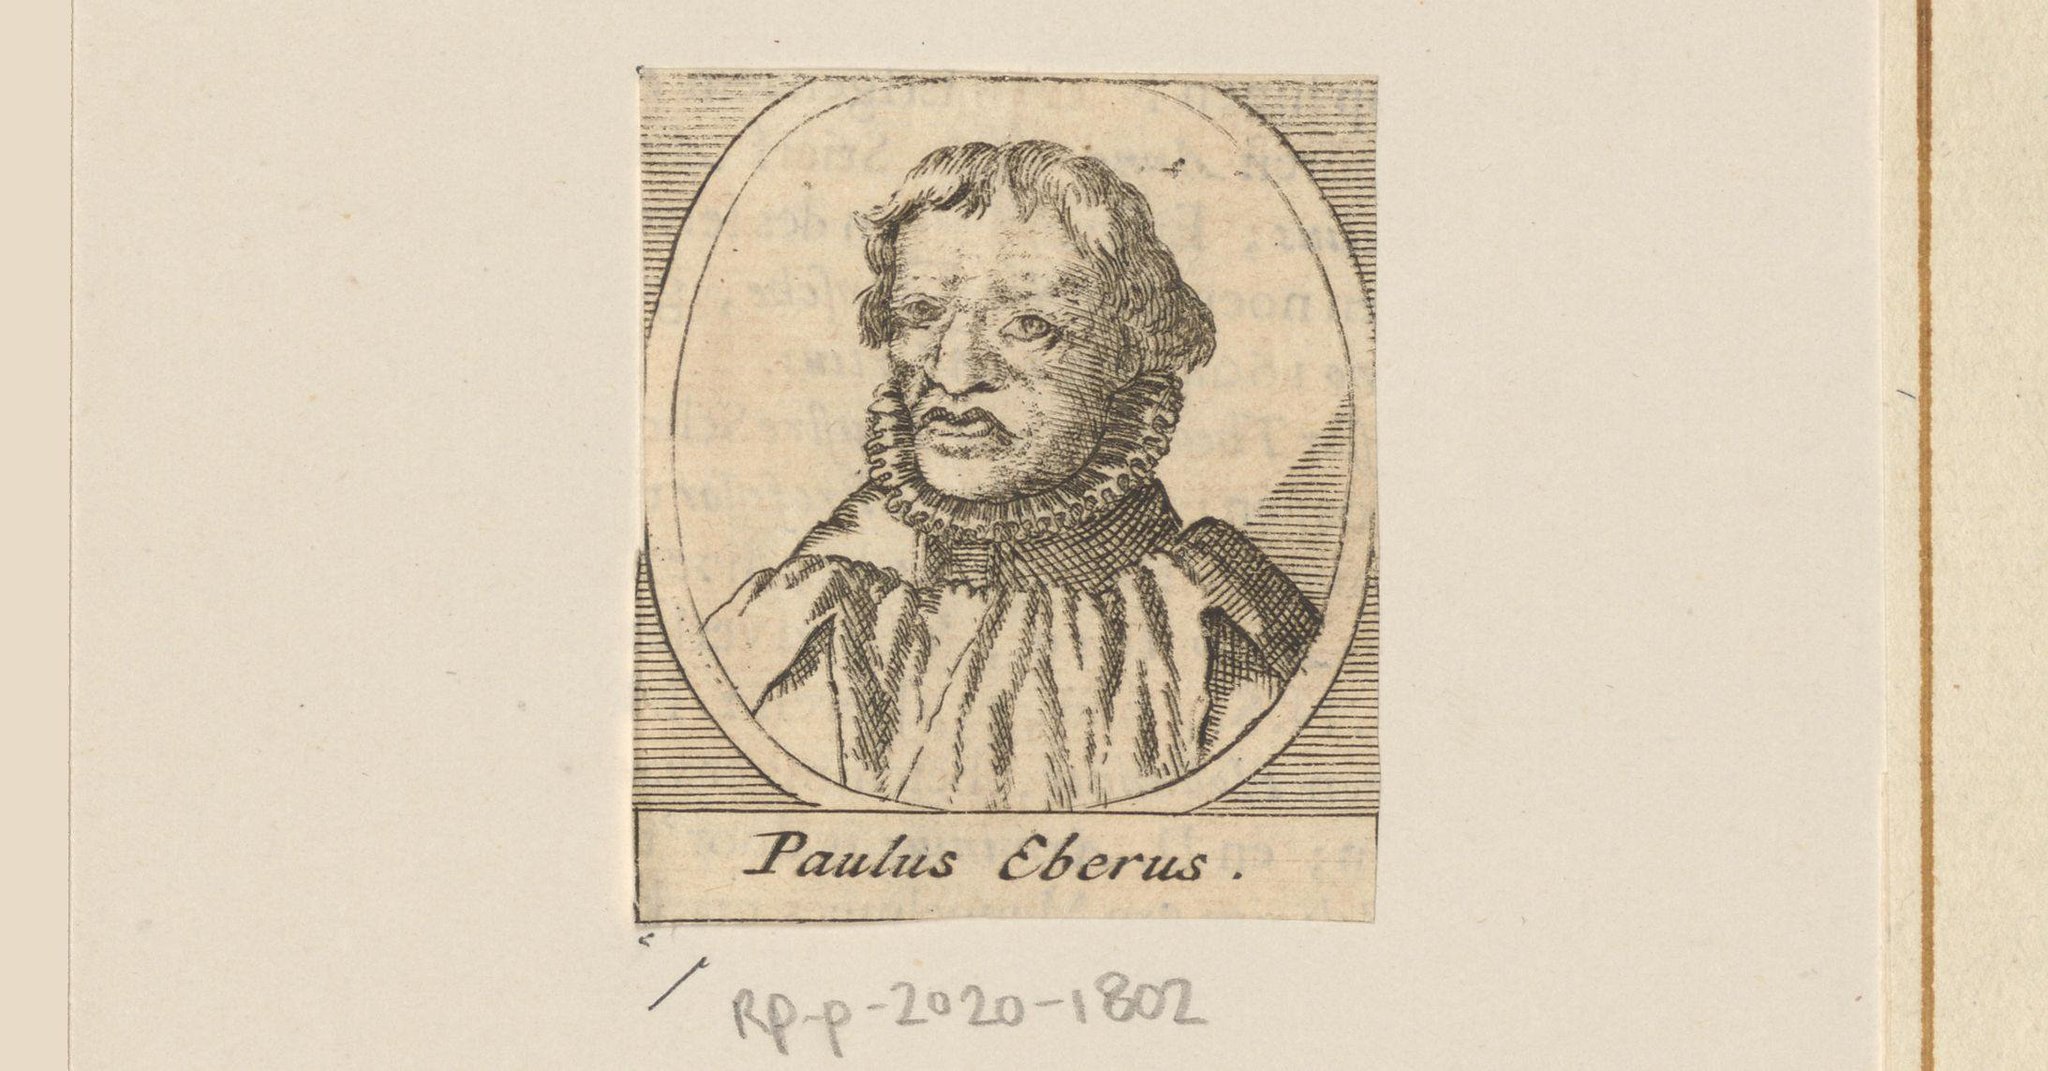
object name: book illustration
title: Portret van Paul Eber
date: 1699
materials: paper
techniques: etching, letterpress printing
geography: northern netherlands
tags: theologian, historical persons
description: Prent uit: Vries, Simon. Algemeene Historische Gedenk-Boeken (...). Leiden: Pieter van der Aa, 1699, dl. 1.